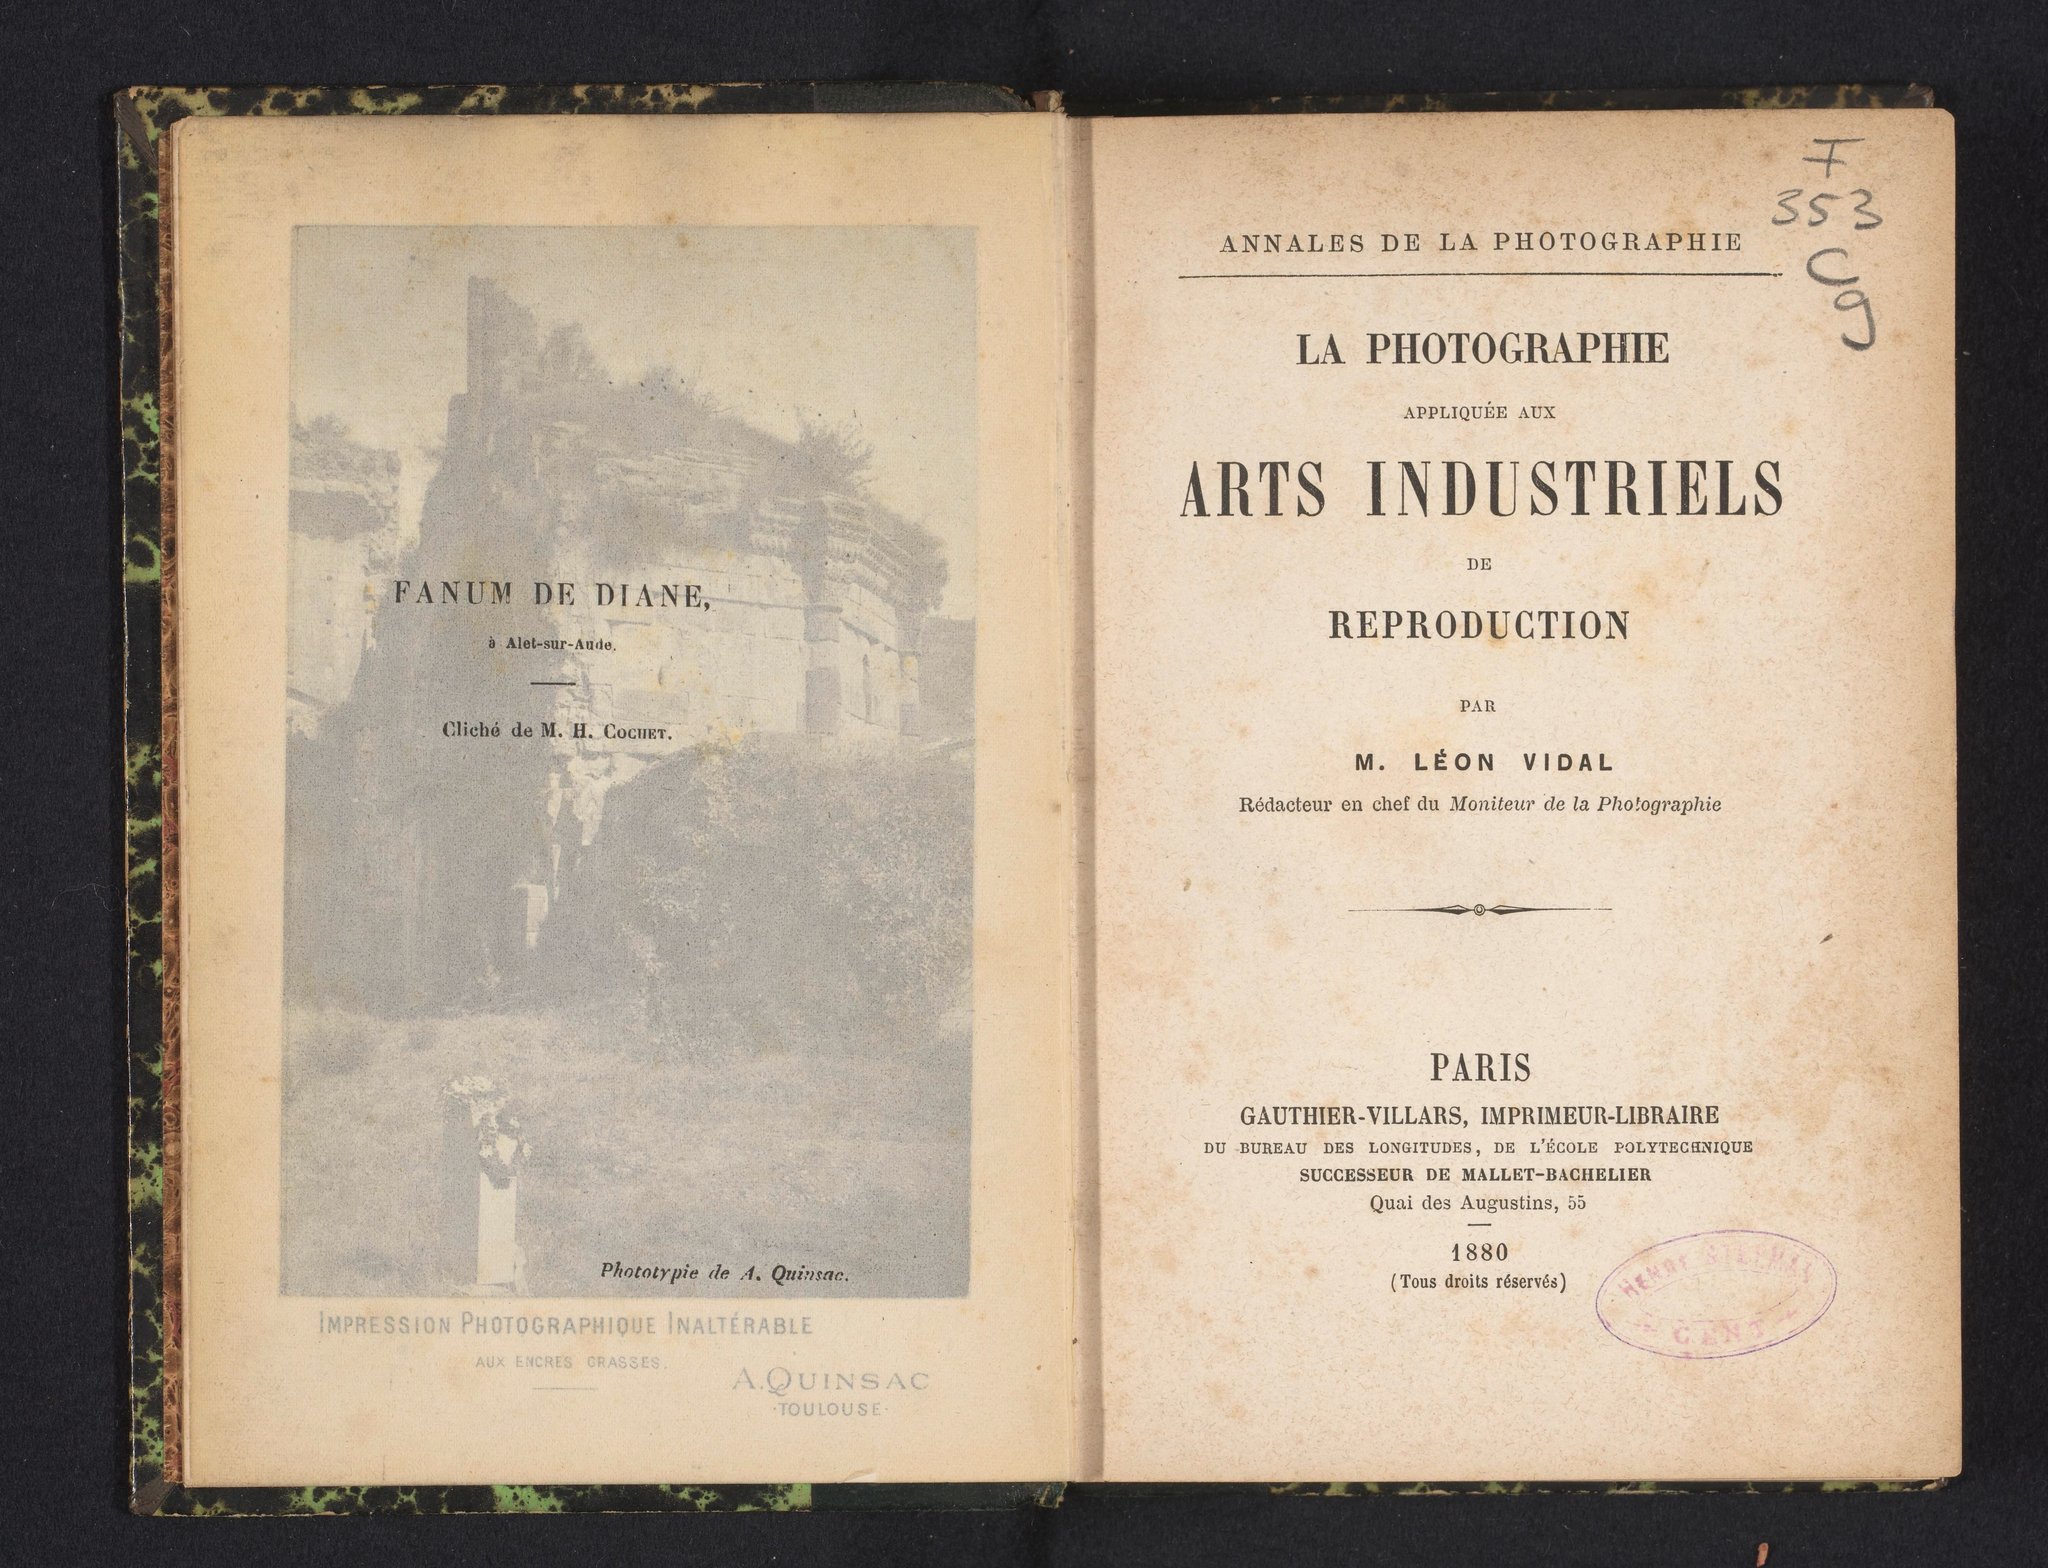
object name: book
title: La photographie appliquée aux arts industriels de reproduction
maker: léon vidal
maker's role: fotograaf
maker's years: 1833-1906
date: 1880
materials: cardboard, linen, paper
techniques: marbled paper, photograph, printing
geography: paris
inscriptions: inscription: ‘Henri Stepman Gent’